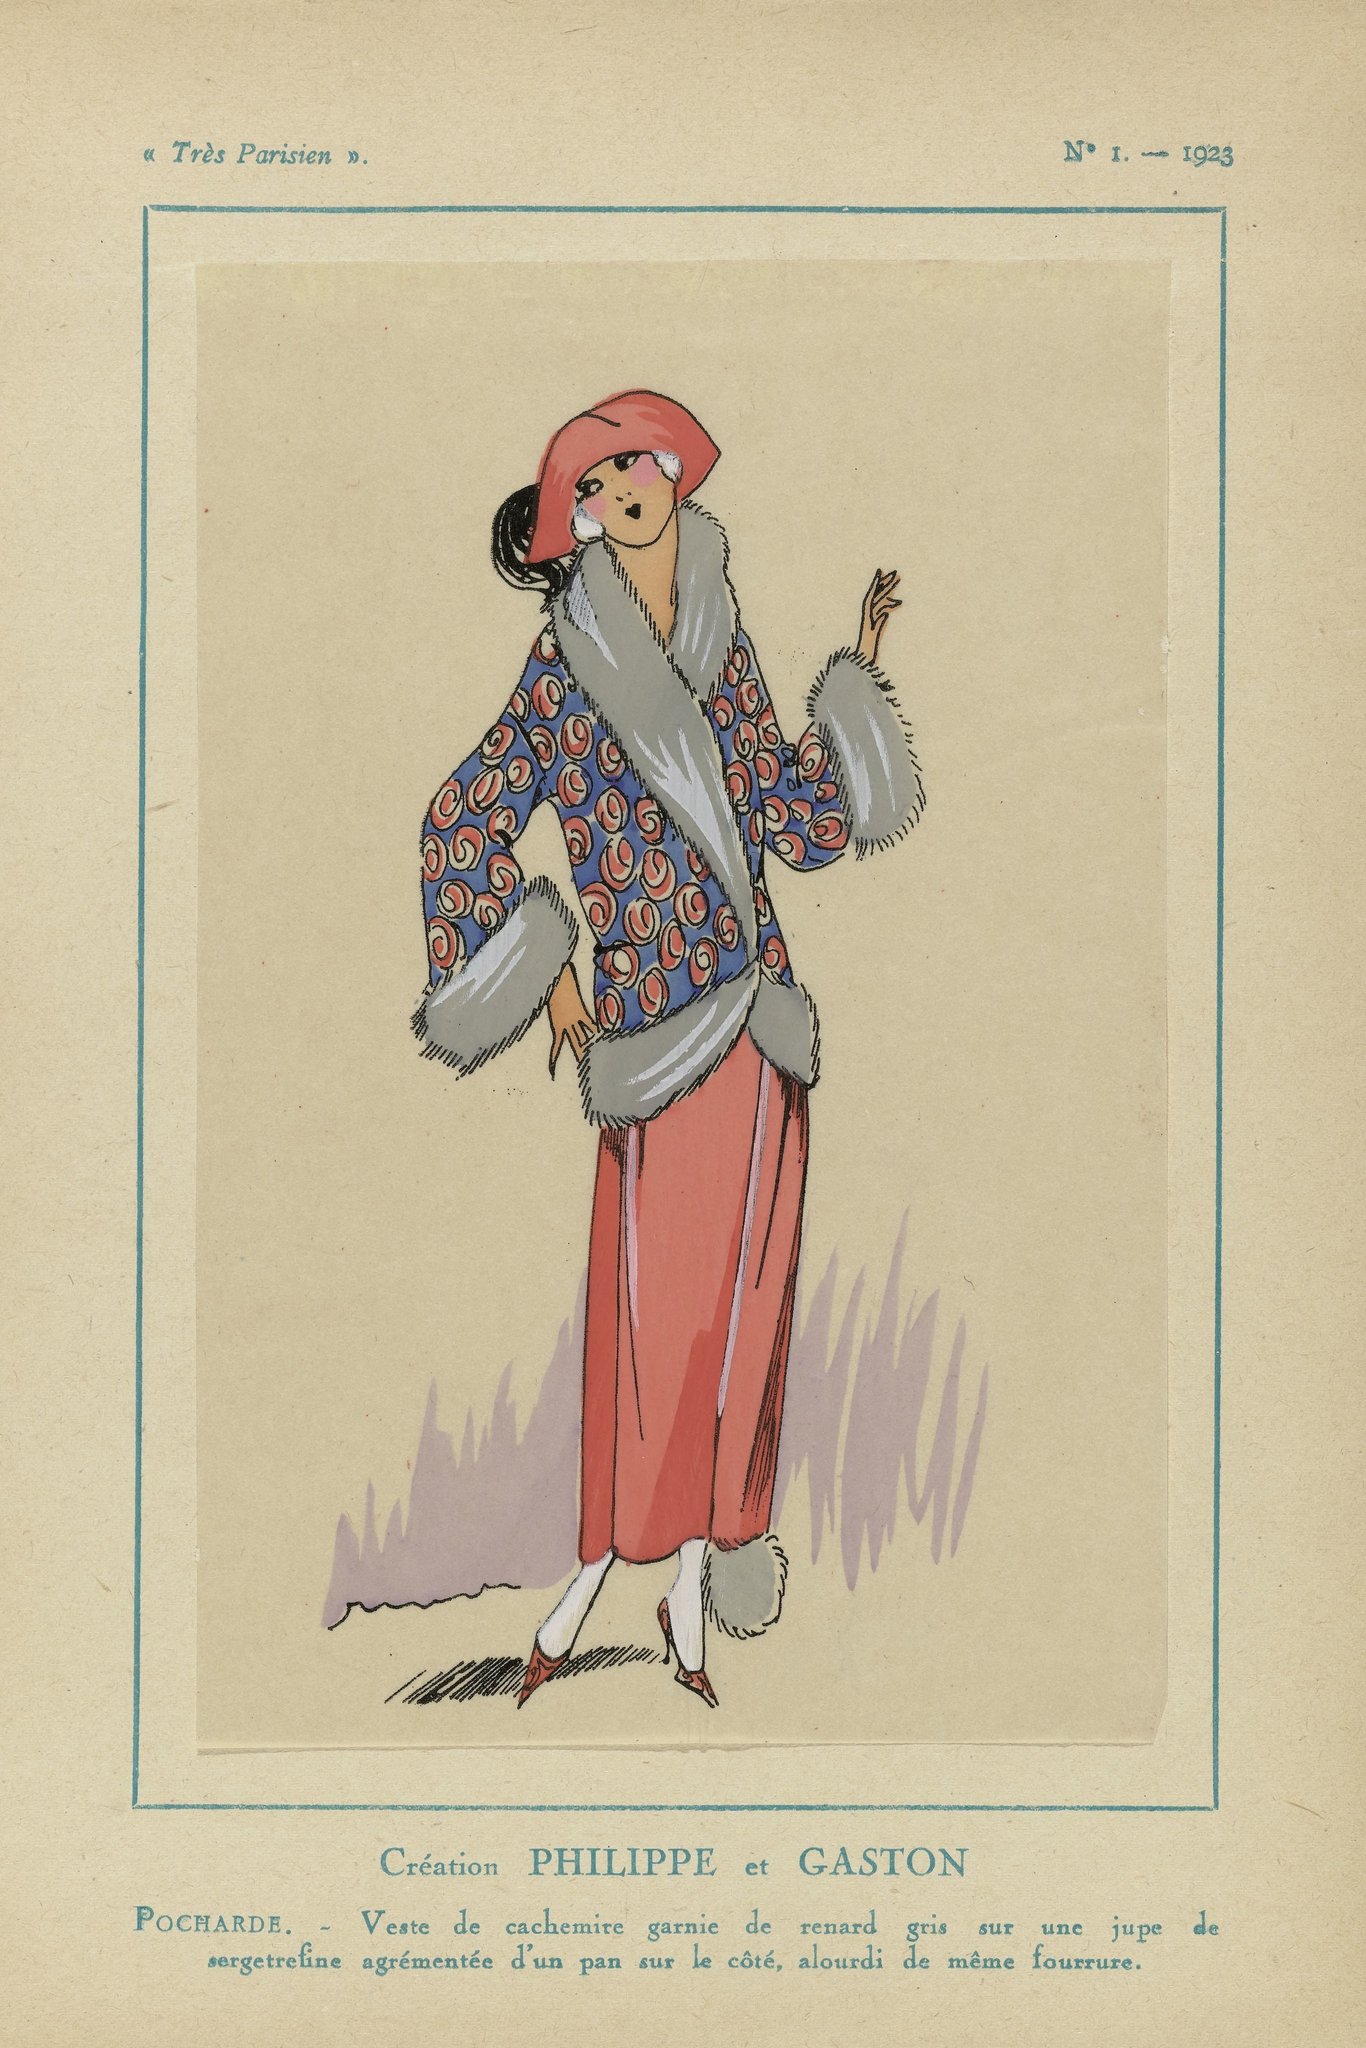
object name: fashion print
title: Très Parisien, 1923, No 1: Création Philippe et Gaston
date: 1923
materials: paper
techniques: hand coloring, letterpress printing, lithography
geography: paris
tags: border, ribbon, braid (+ fur used for clothes), coat (+ women's clothes), fashion plates, head-gear: hat (+ women's clothes), skirt (+ women's clothes)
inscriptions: title: ‘Très Parisien / No 1. - 1923’, caption: ‘Création PHILIPPE et GASTON / POCHARDE. - Veste de cachemire garnie de renard gris sur une jupe de sergetrefine agrémentée d'un pan sur le côté, alourdi de même fourrure.’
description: Créatie van het modehuis PHILIPPE et GASTON. Vest van kasjmier, gegarneerd met grijs vossenbont, op een rode rok met aan de zijkant een versiering van hetzelfde bont. Prent uit het modetijdschrift Très Parisien (1920-1936).